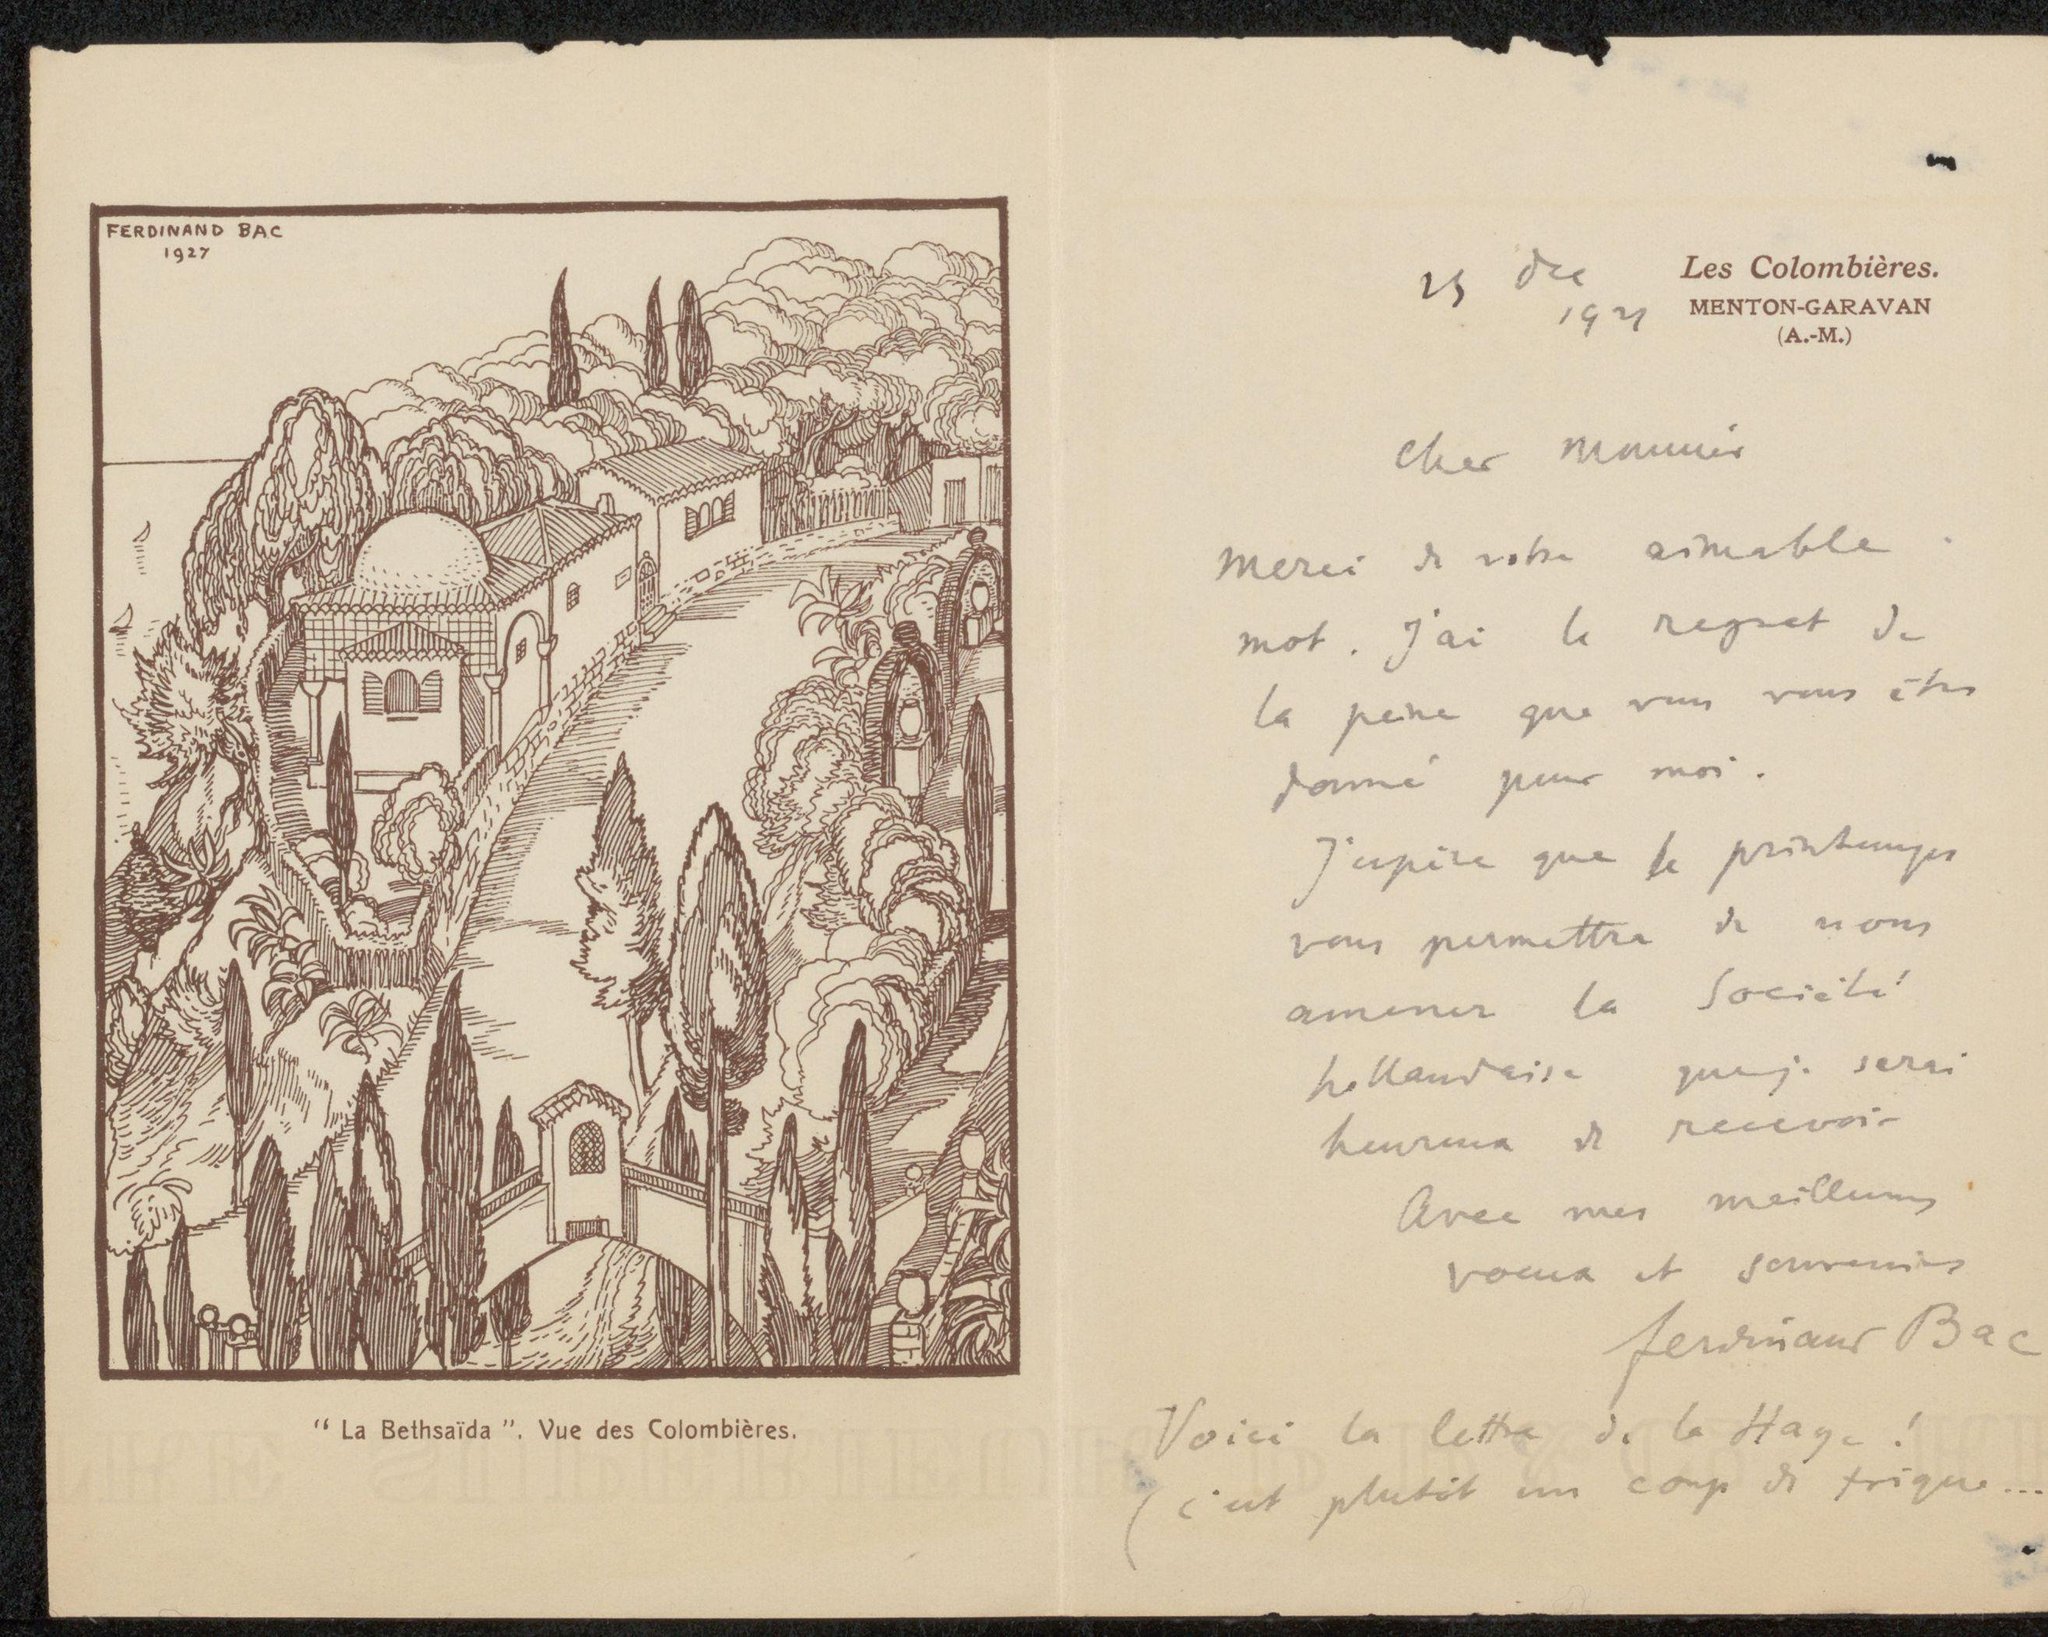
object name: letter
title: Brief aan Philip Zilcken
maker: ferdinand-sigismund bac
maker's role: draughtsman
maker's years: 1859-1952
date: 1927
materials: ink, paper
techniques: pen, printing, writing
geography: menton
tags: the hague, painter, philip zilcken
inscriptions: collector's mark: ‘RPK’